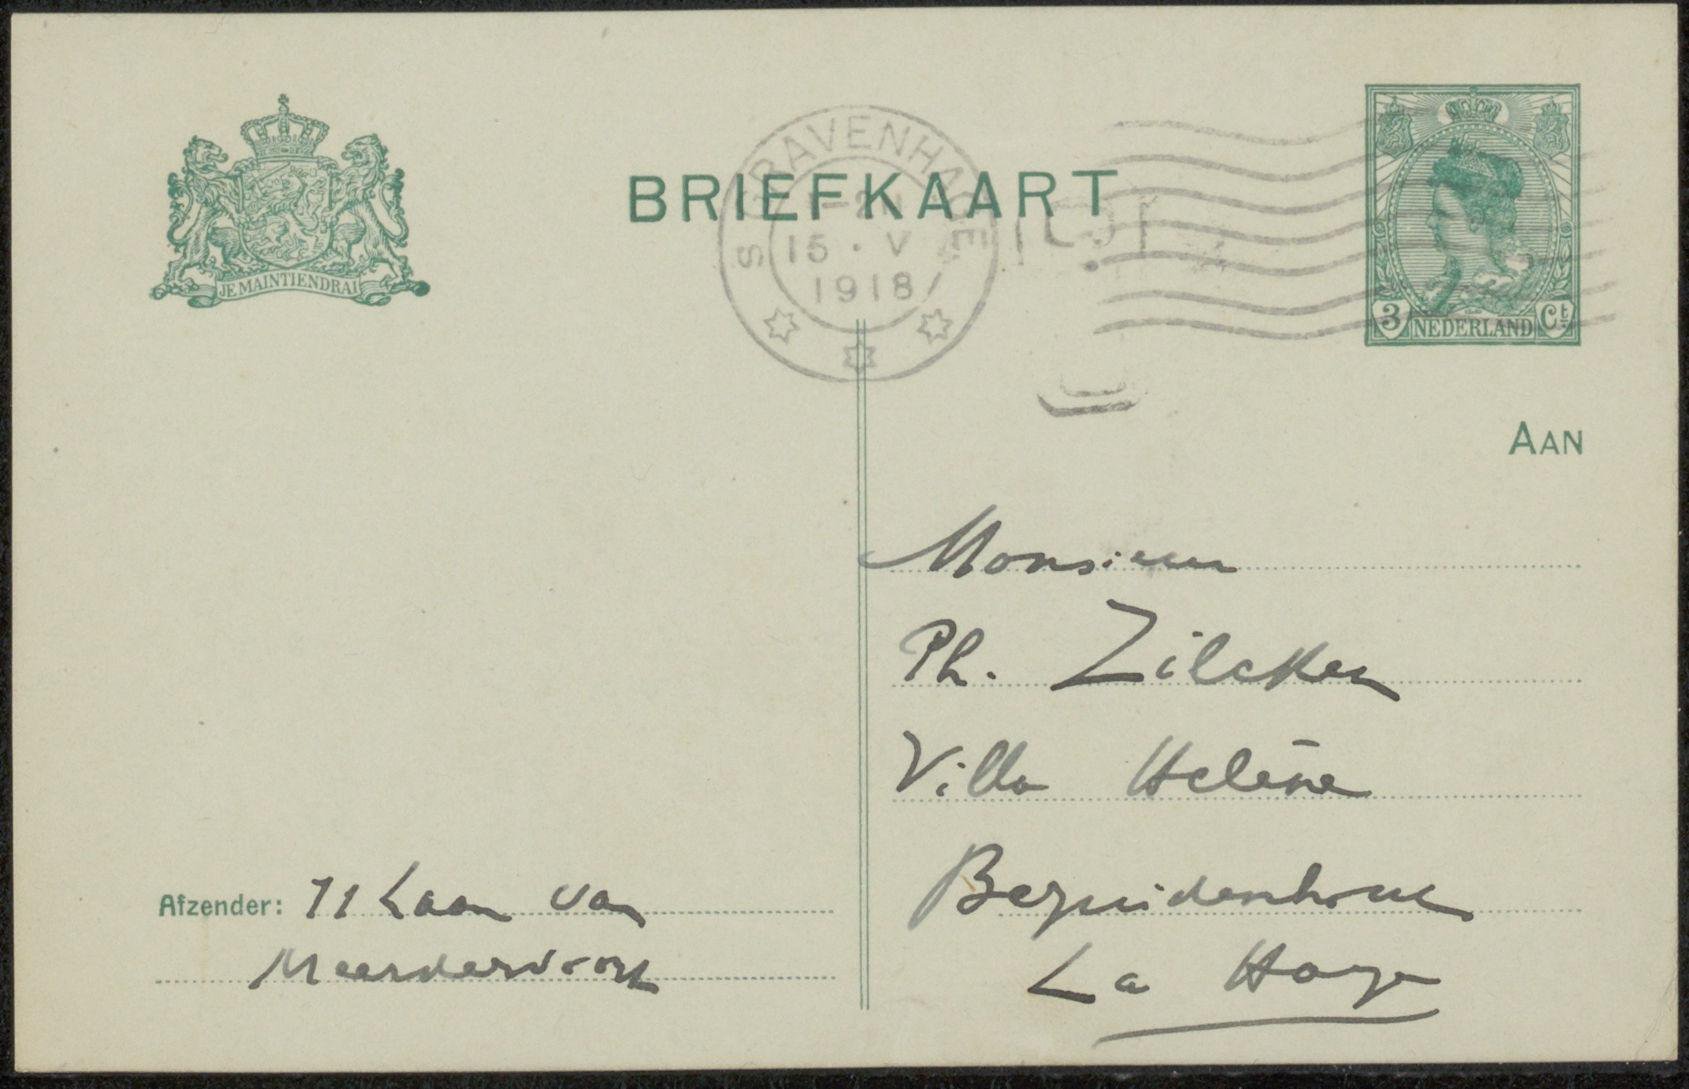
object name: postcard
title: Briefkaart aan Philip Zilcken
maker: cyriel buysse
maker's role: schrijver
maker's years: 1859-1932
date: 1918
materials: cardboard, ink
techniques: pen, writing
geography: the hague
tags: the hague, painter, draughtsman, philip zilcken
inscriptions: collector's mark: ‘RPK’